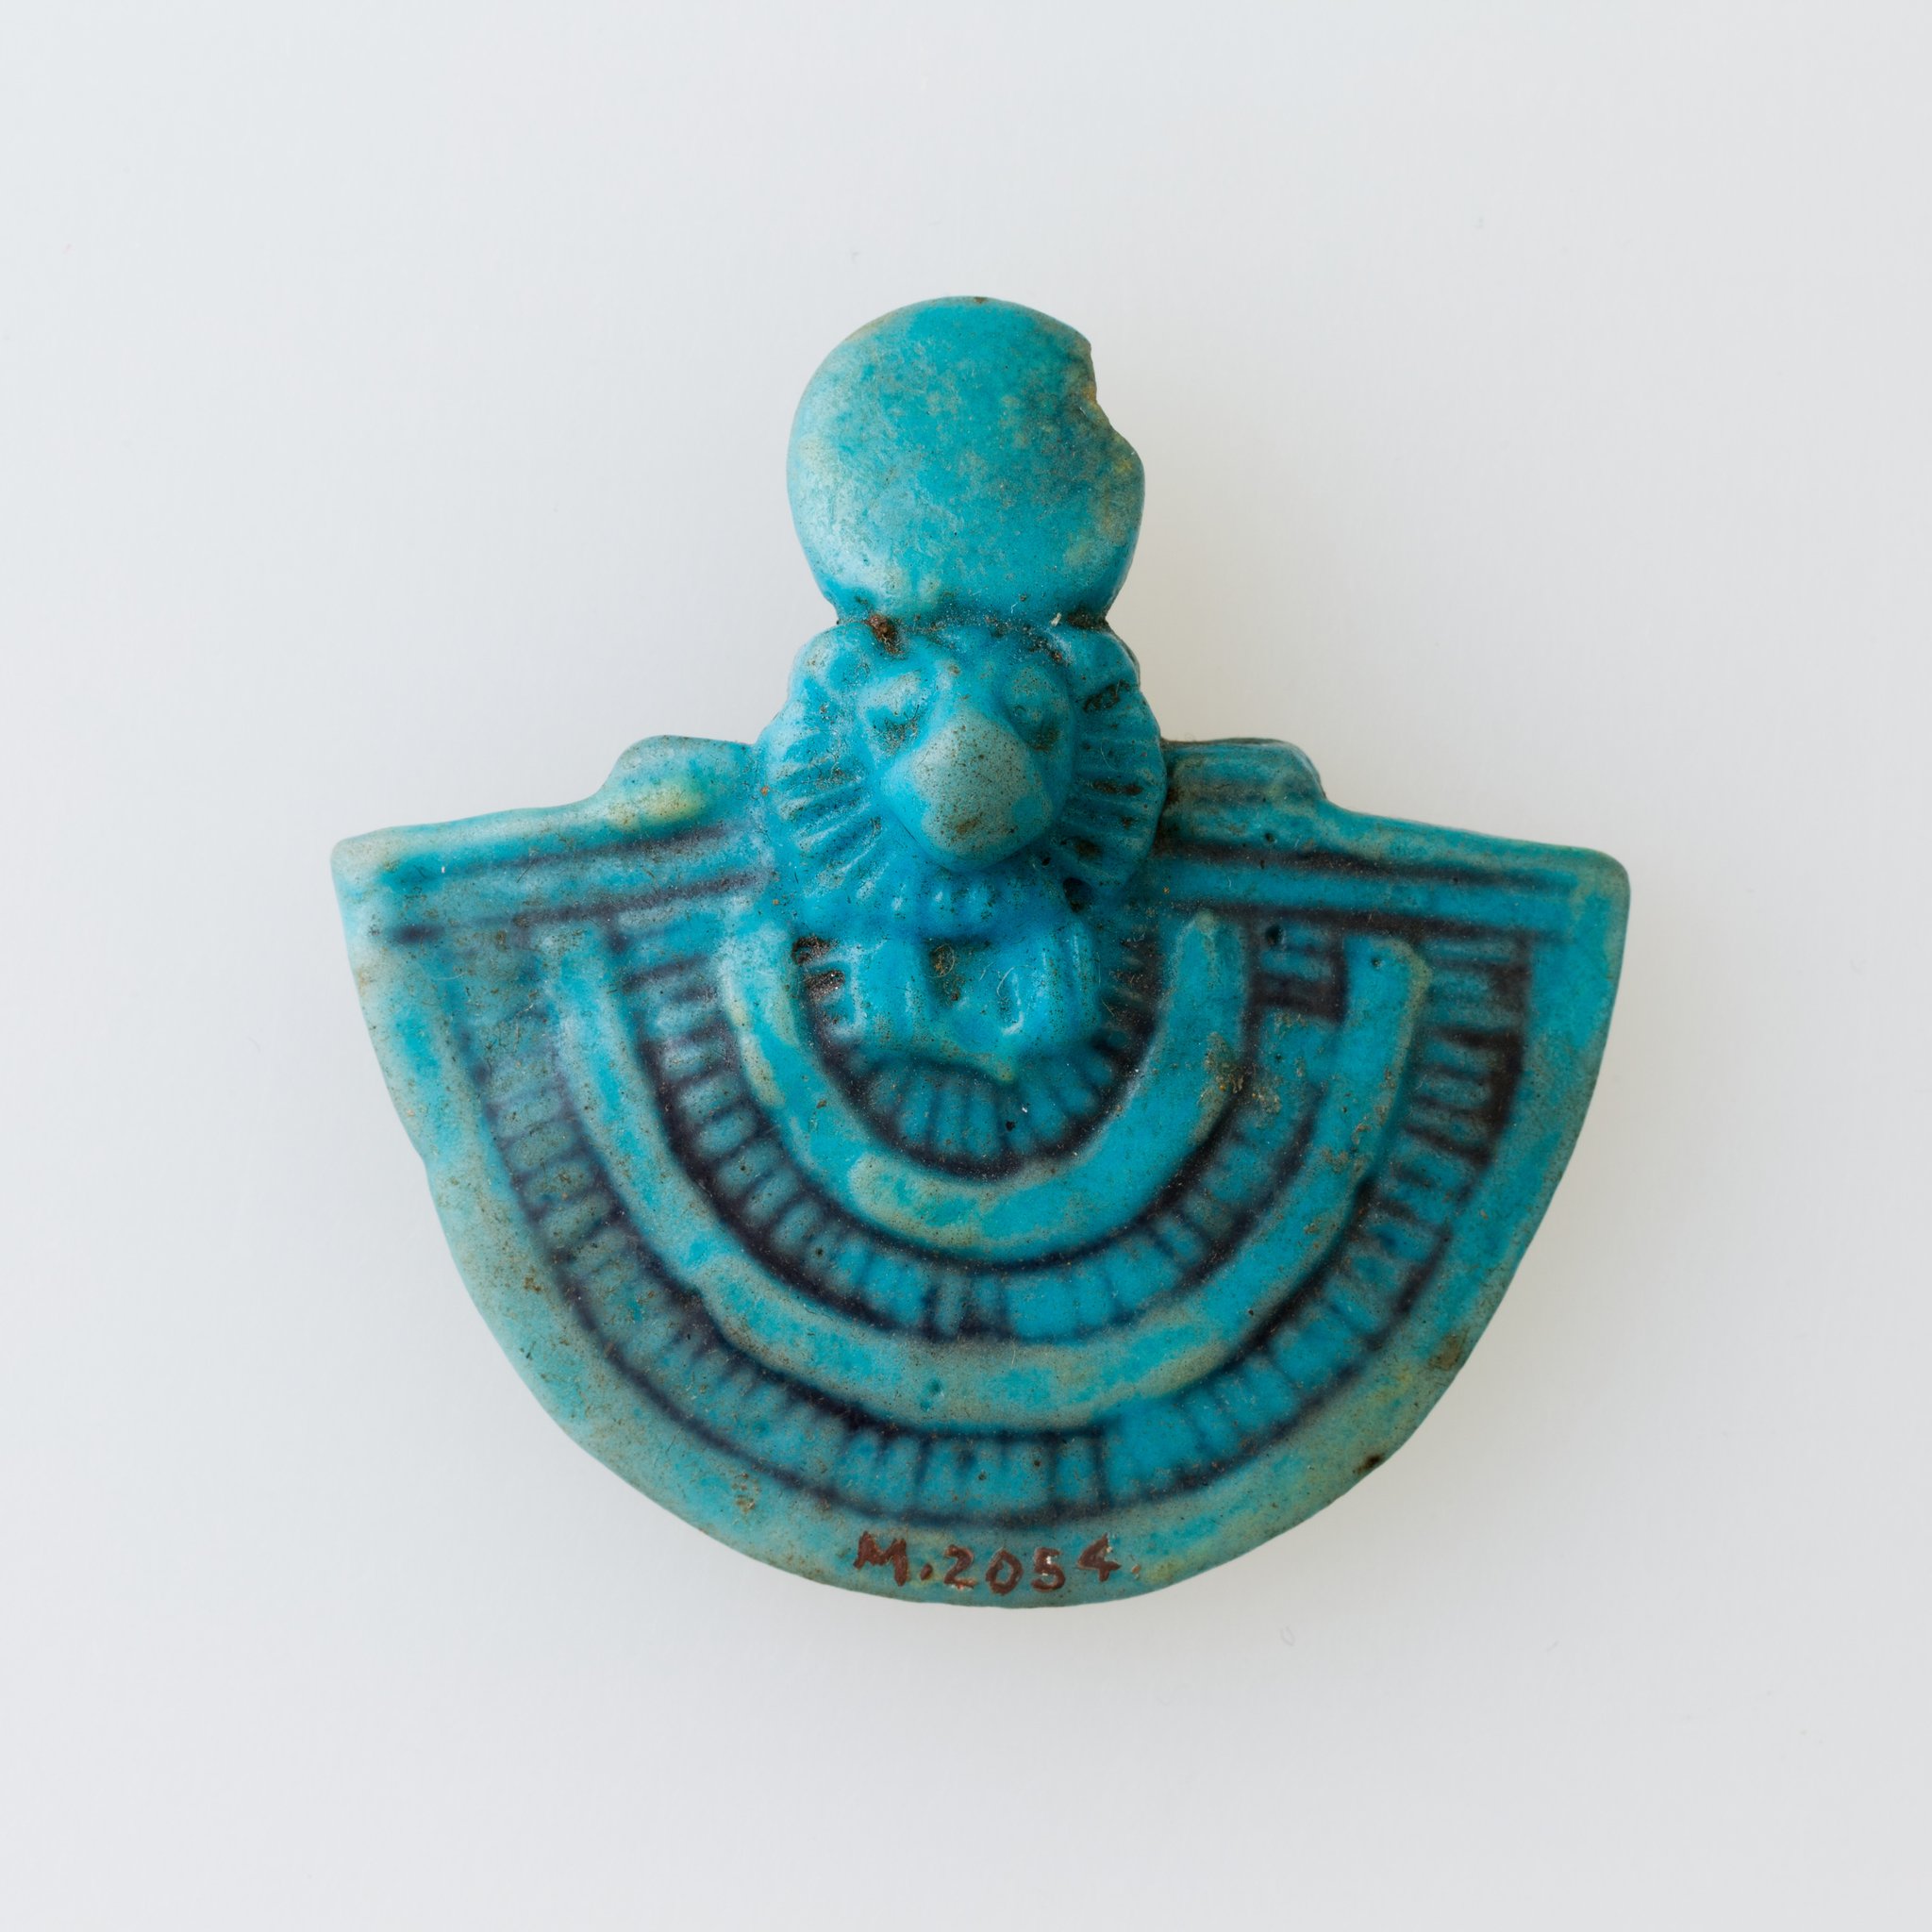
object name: amulet, aegis, bastet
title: Aegis of Sakhmet or Bastet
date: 664-630 BCE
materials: faience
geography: egypt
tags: lions